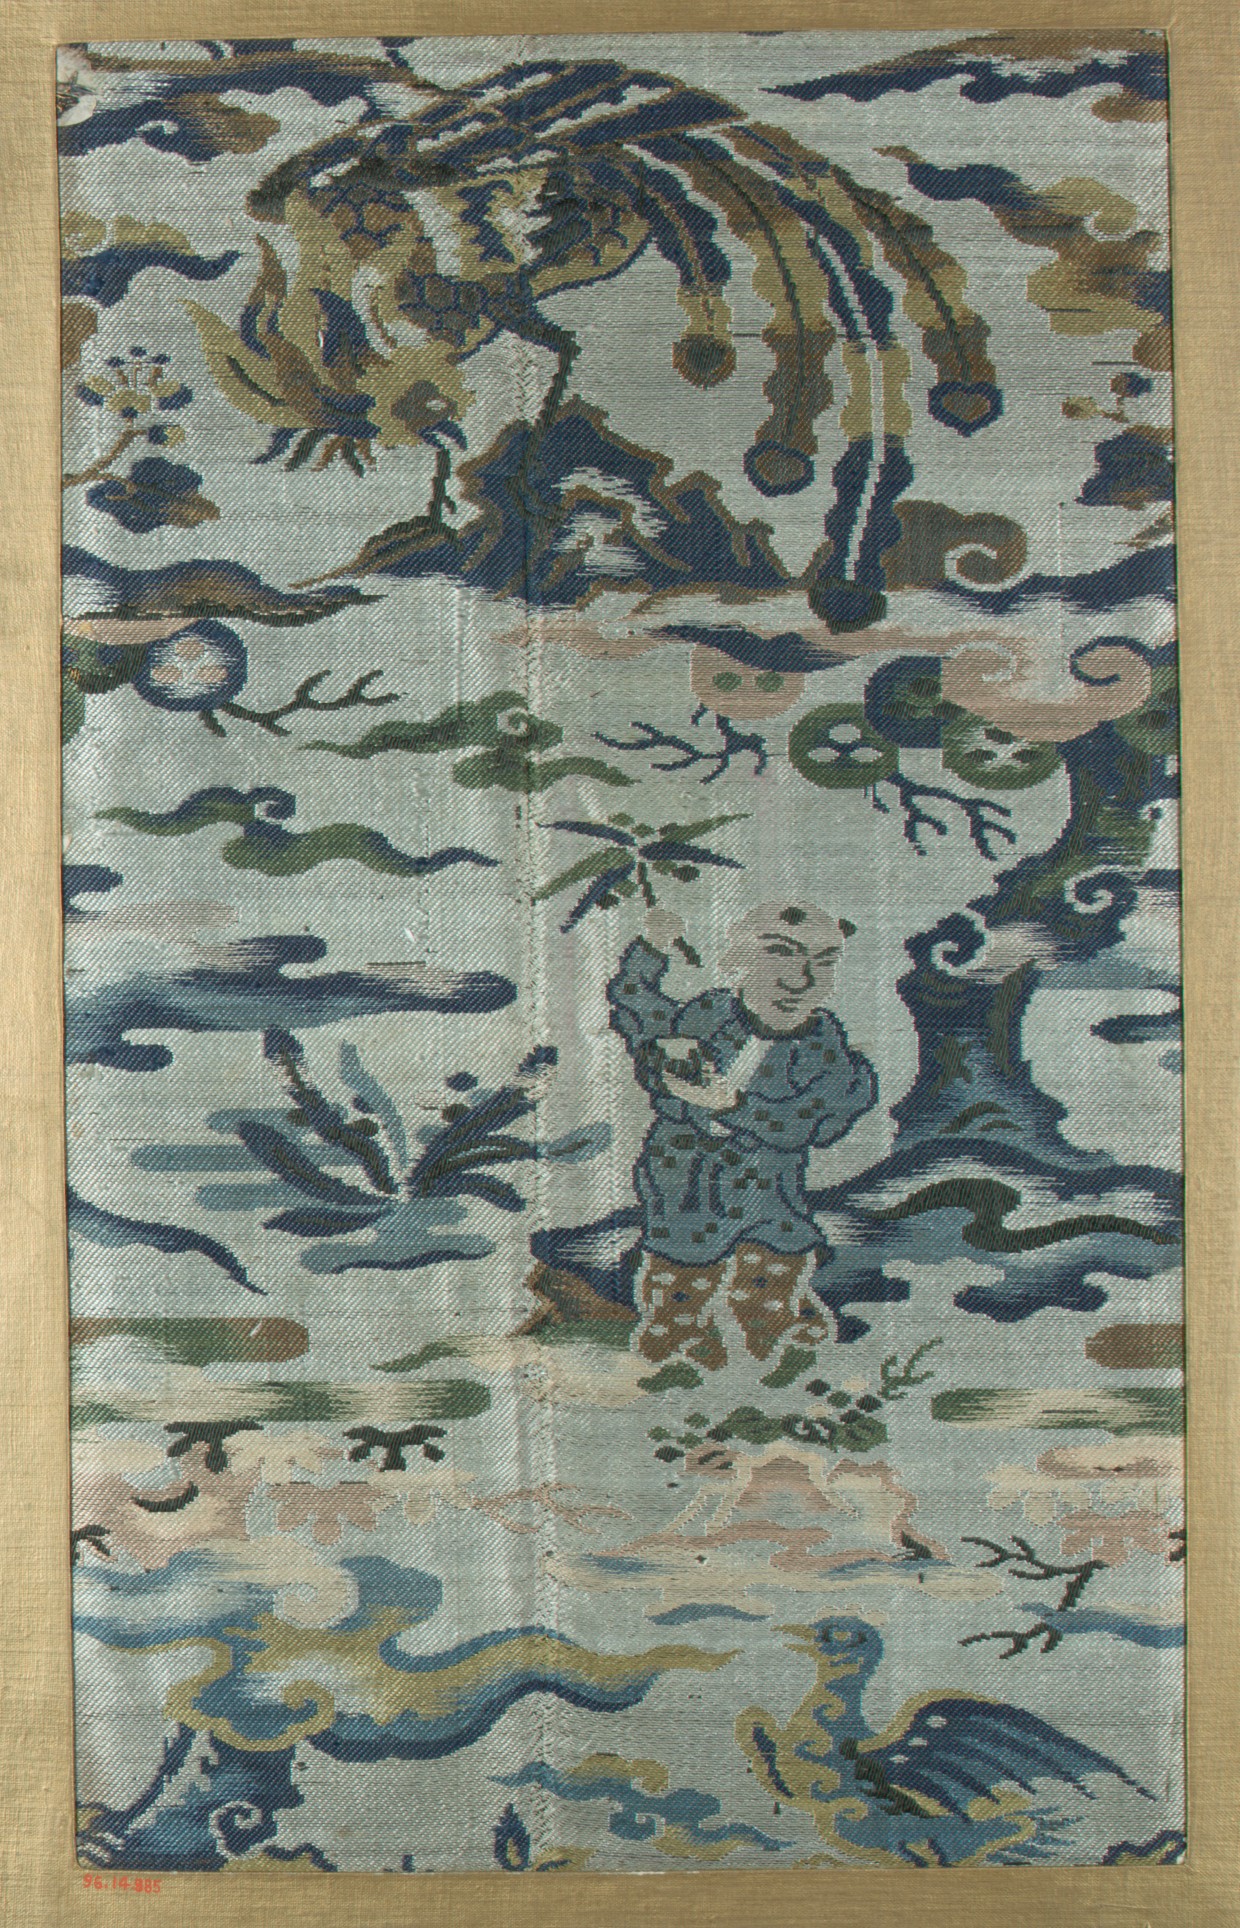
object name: piece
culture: japanese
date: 1701-1900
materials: silk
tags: men